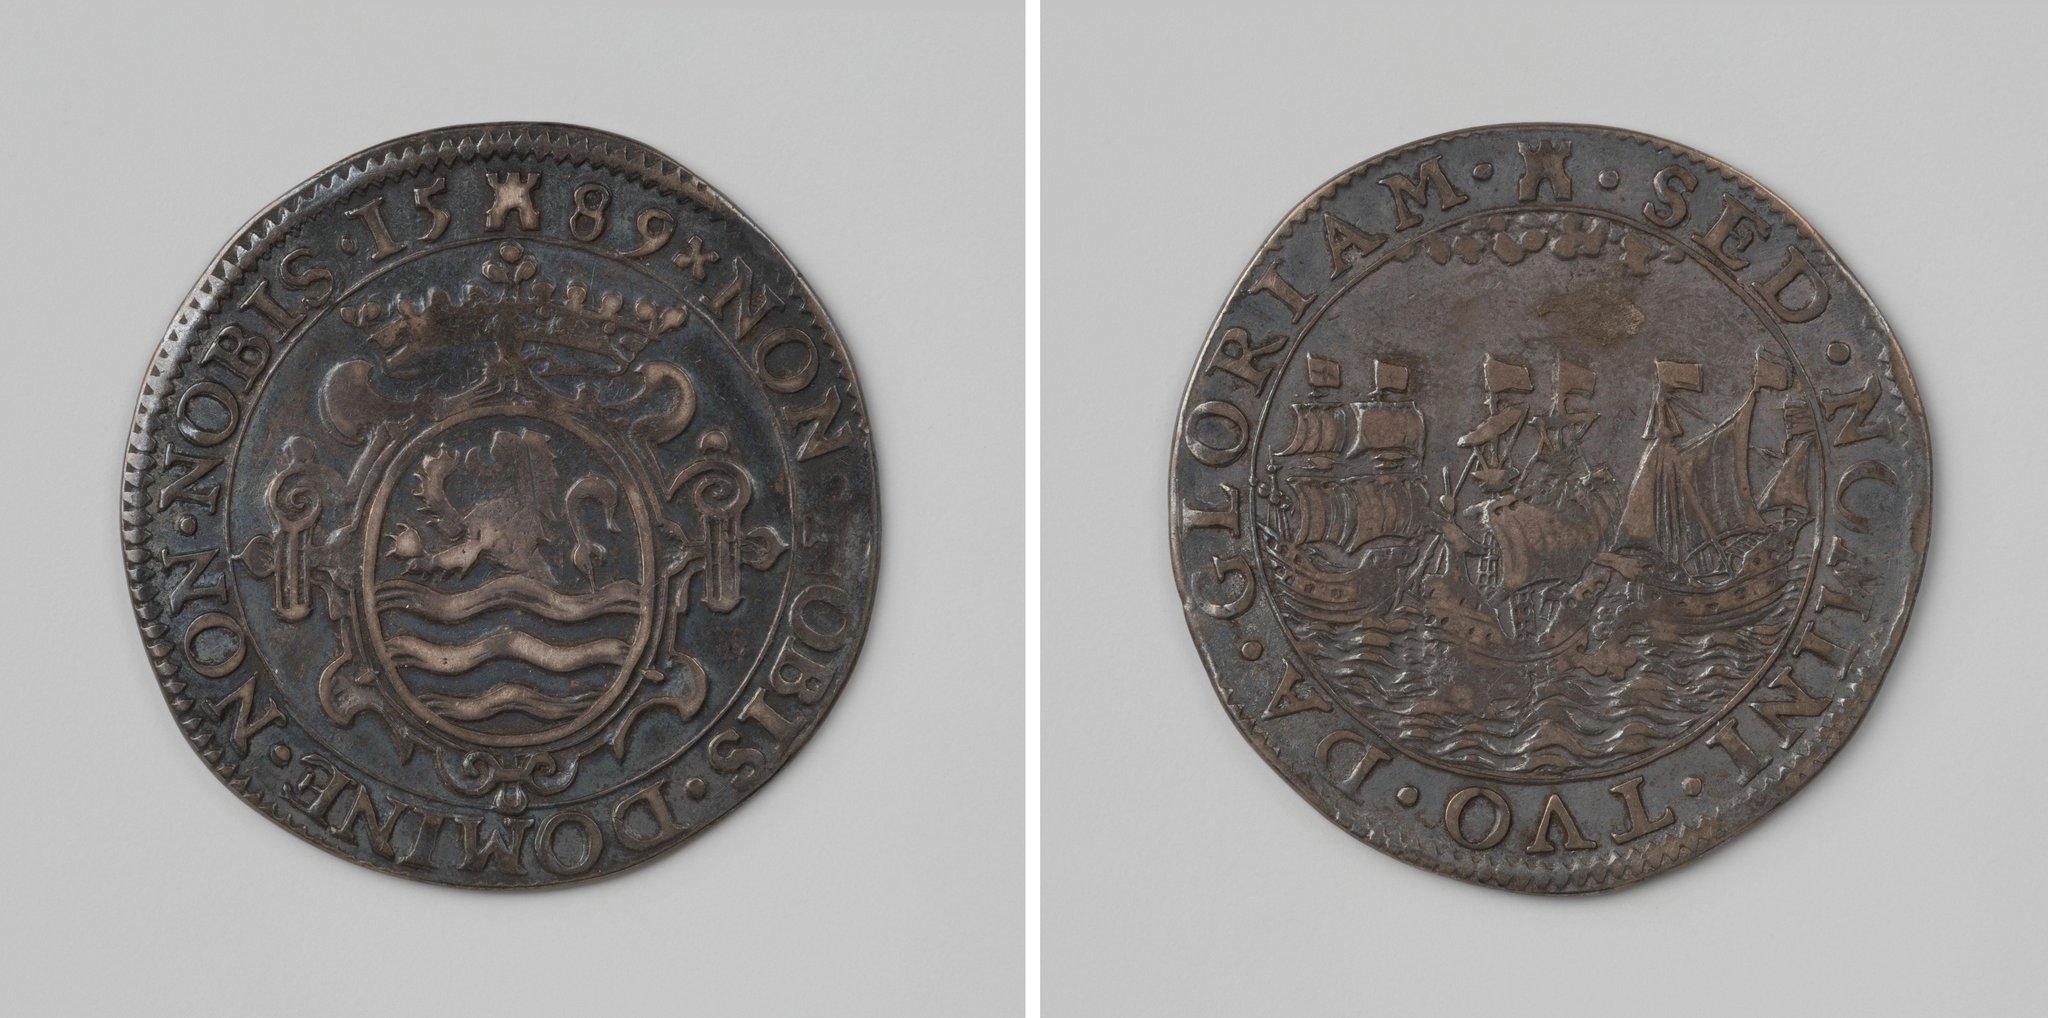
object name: jeton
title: Vergaan van de Spaanse armada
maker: Anonymous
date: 1589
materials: silver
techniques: striking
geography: middelburg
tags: zeeland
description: Zilveren penning. Voorzijde: gekroond wapenschild in cartouche binnen omschrift. Keerzijde: vluchtende Spaanse vloot binnen omschrift